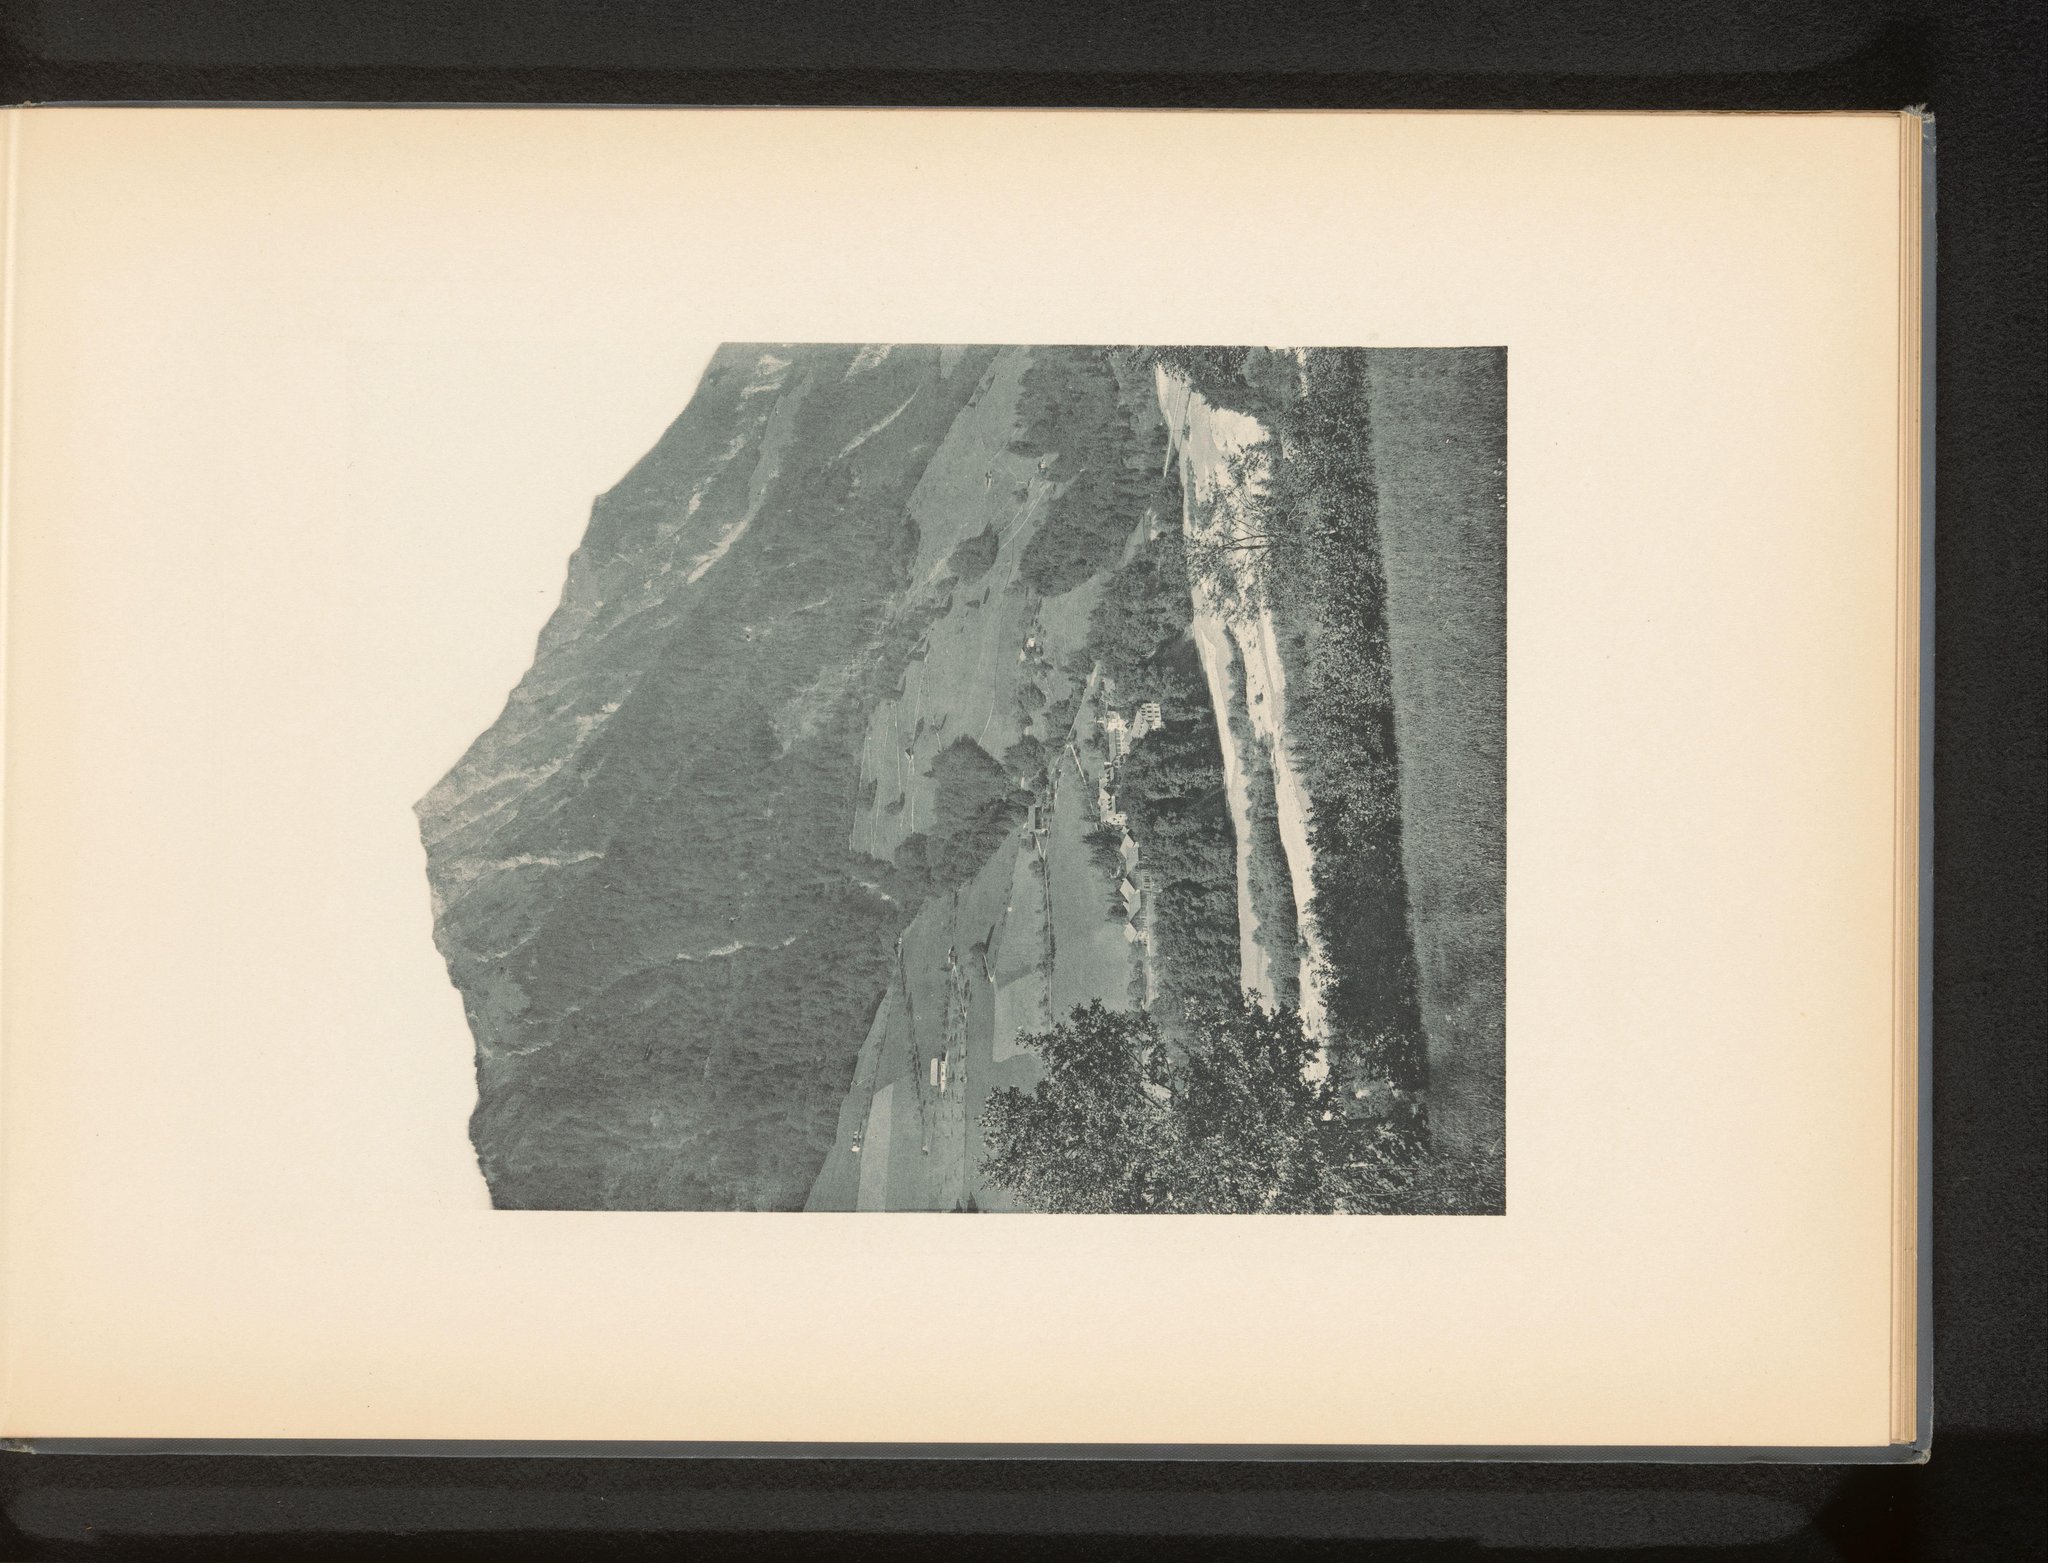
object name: photomechanical print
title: Gezicht op de omgeving van Heustrich-les-bains bij Spiez, Zwitserland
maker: Anonymous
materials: paper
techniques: photograph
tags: landscapes, mountains